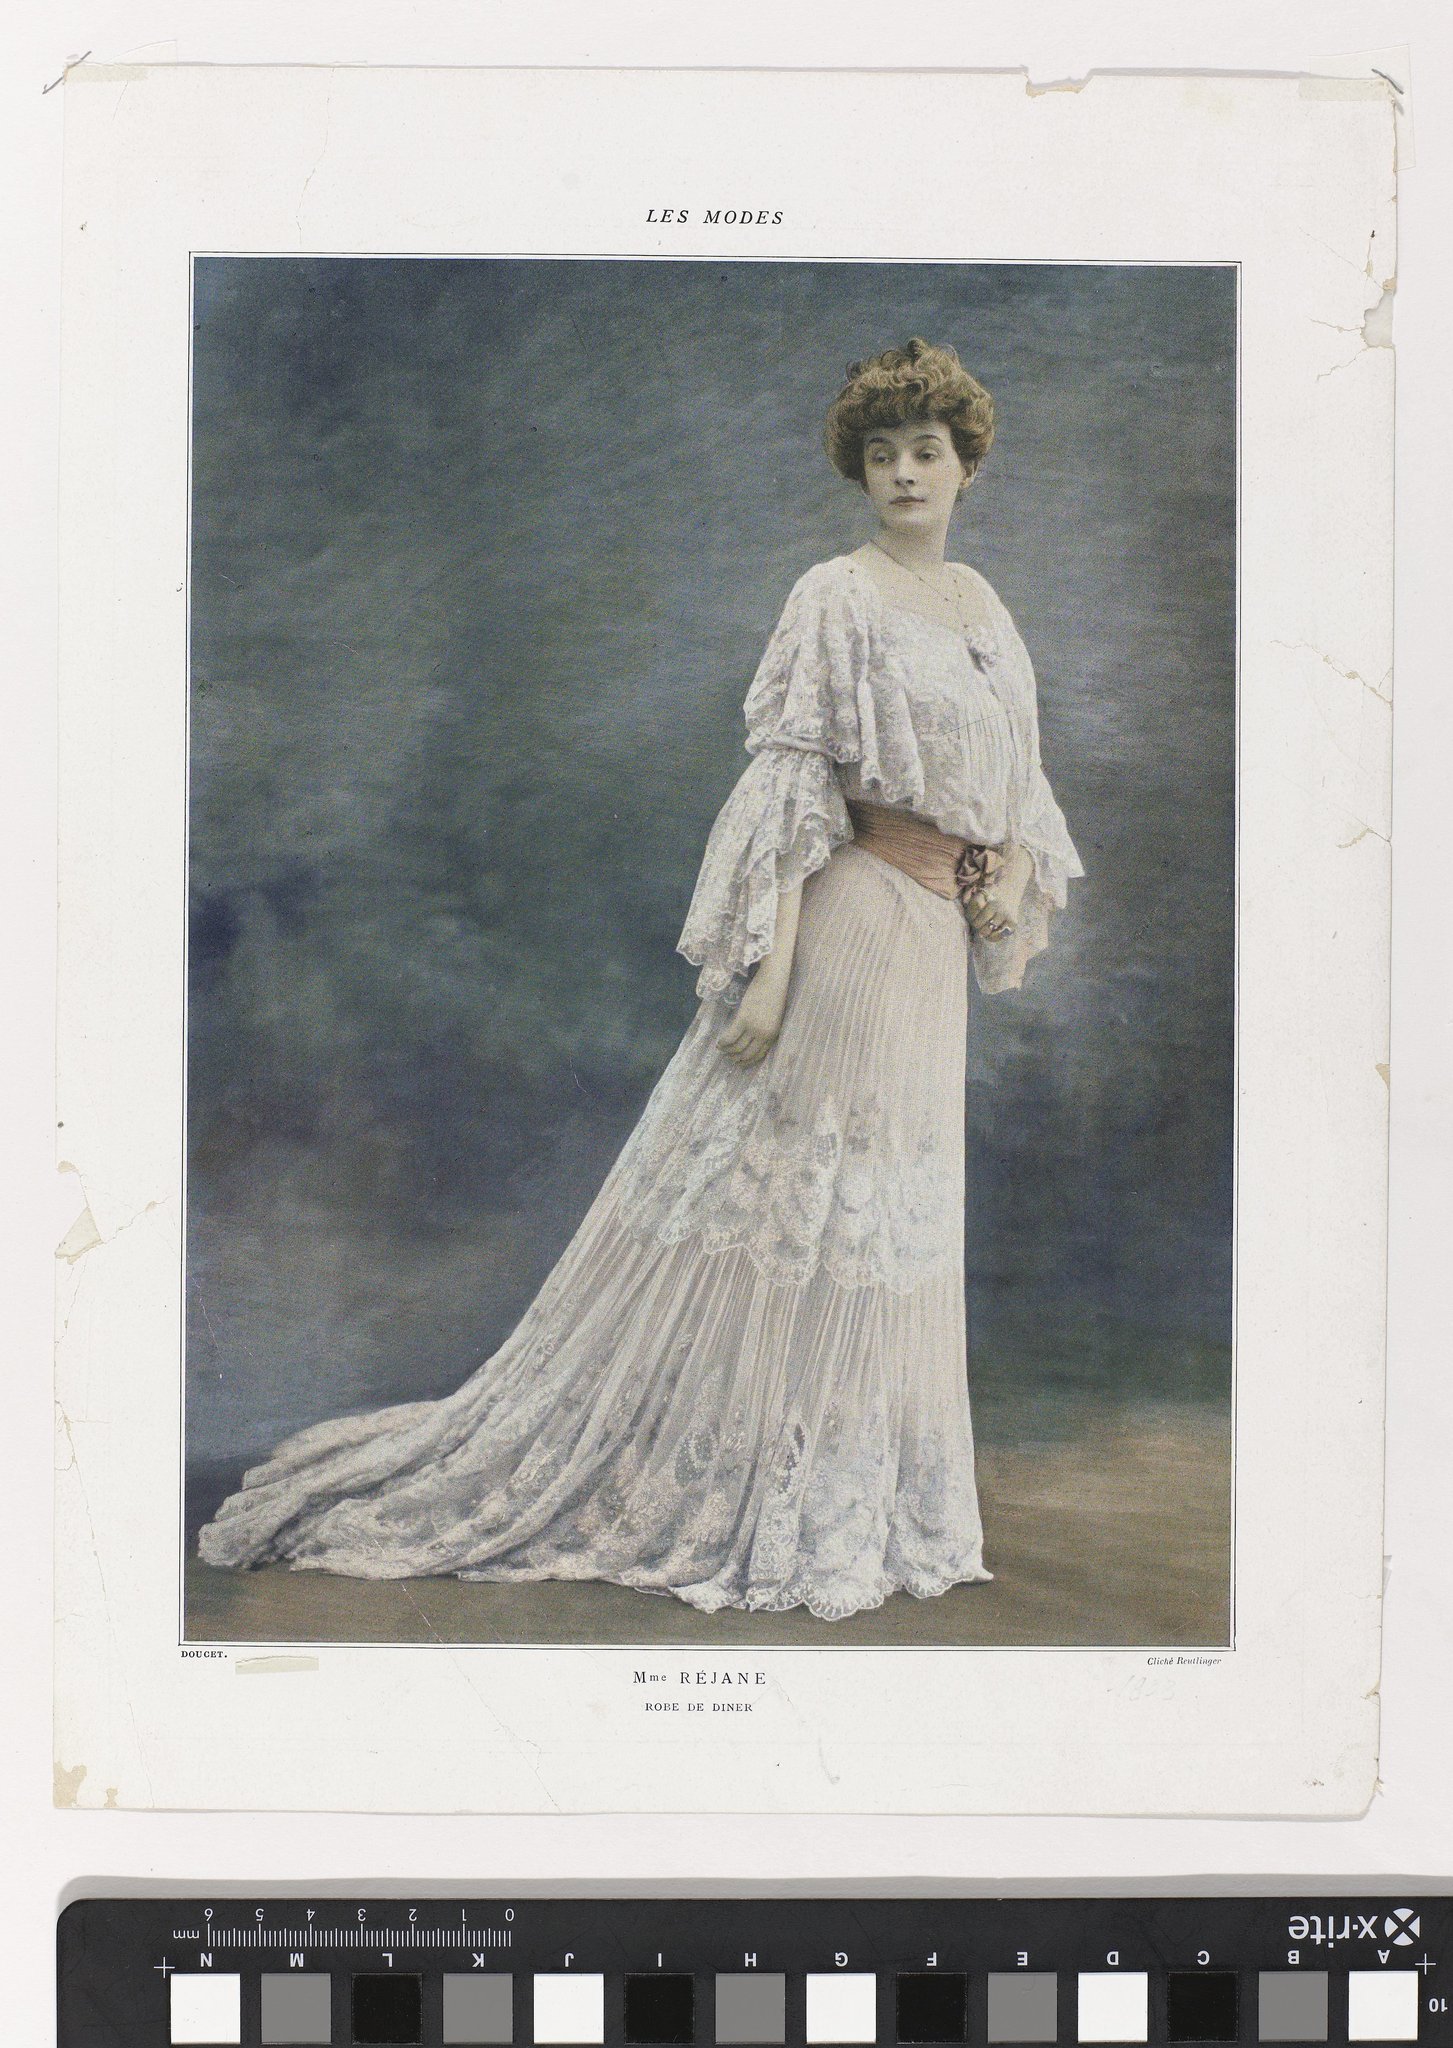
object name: fashion print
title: Les Modes, 1903 : Mme Réjane / ROBE DE DINER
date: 1903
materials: paper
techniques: printing, photochemical processes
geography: paris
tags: ring (+ women's clothes), dress, gown: dinner dress (+ women's clothes), fashion plates, necklace (+ women's clothes), belt, girdle, waistband (+ women's clothes)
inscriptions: caption: ‘DOUCET. / Mme RÉJANE ROBE DE DINER / Cliché Reutlinger’, title: ‘LES MODES’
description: Volgens het onderschrift is dit de Franse actrice Gabrielle Réjane (1856–1920) in een dinerjapon van Doucet. Accessoires: collier, ceintuur, ringen. Prent uit het modetijdschrift Les Modes (1901-1937).